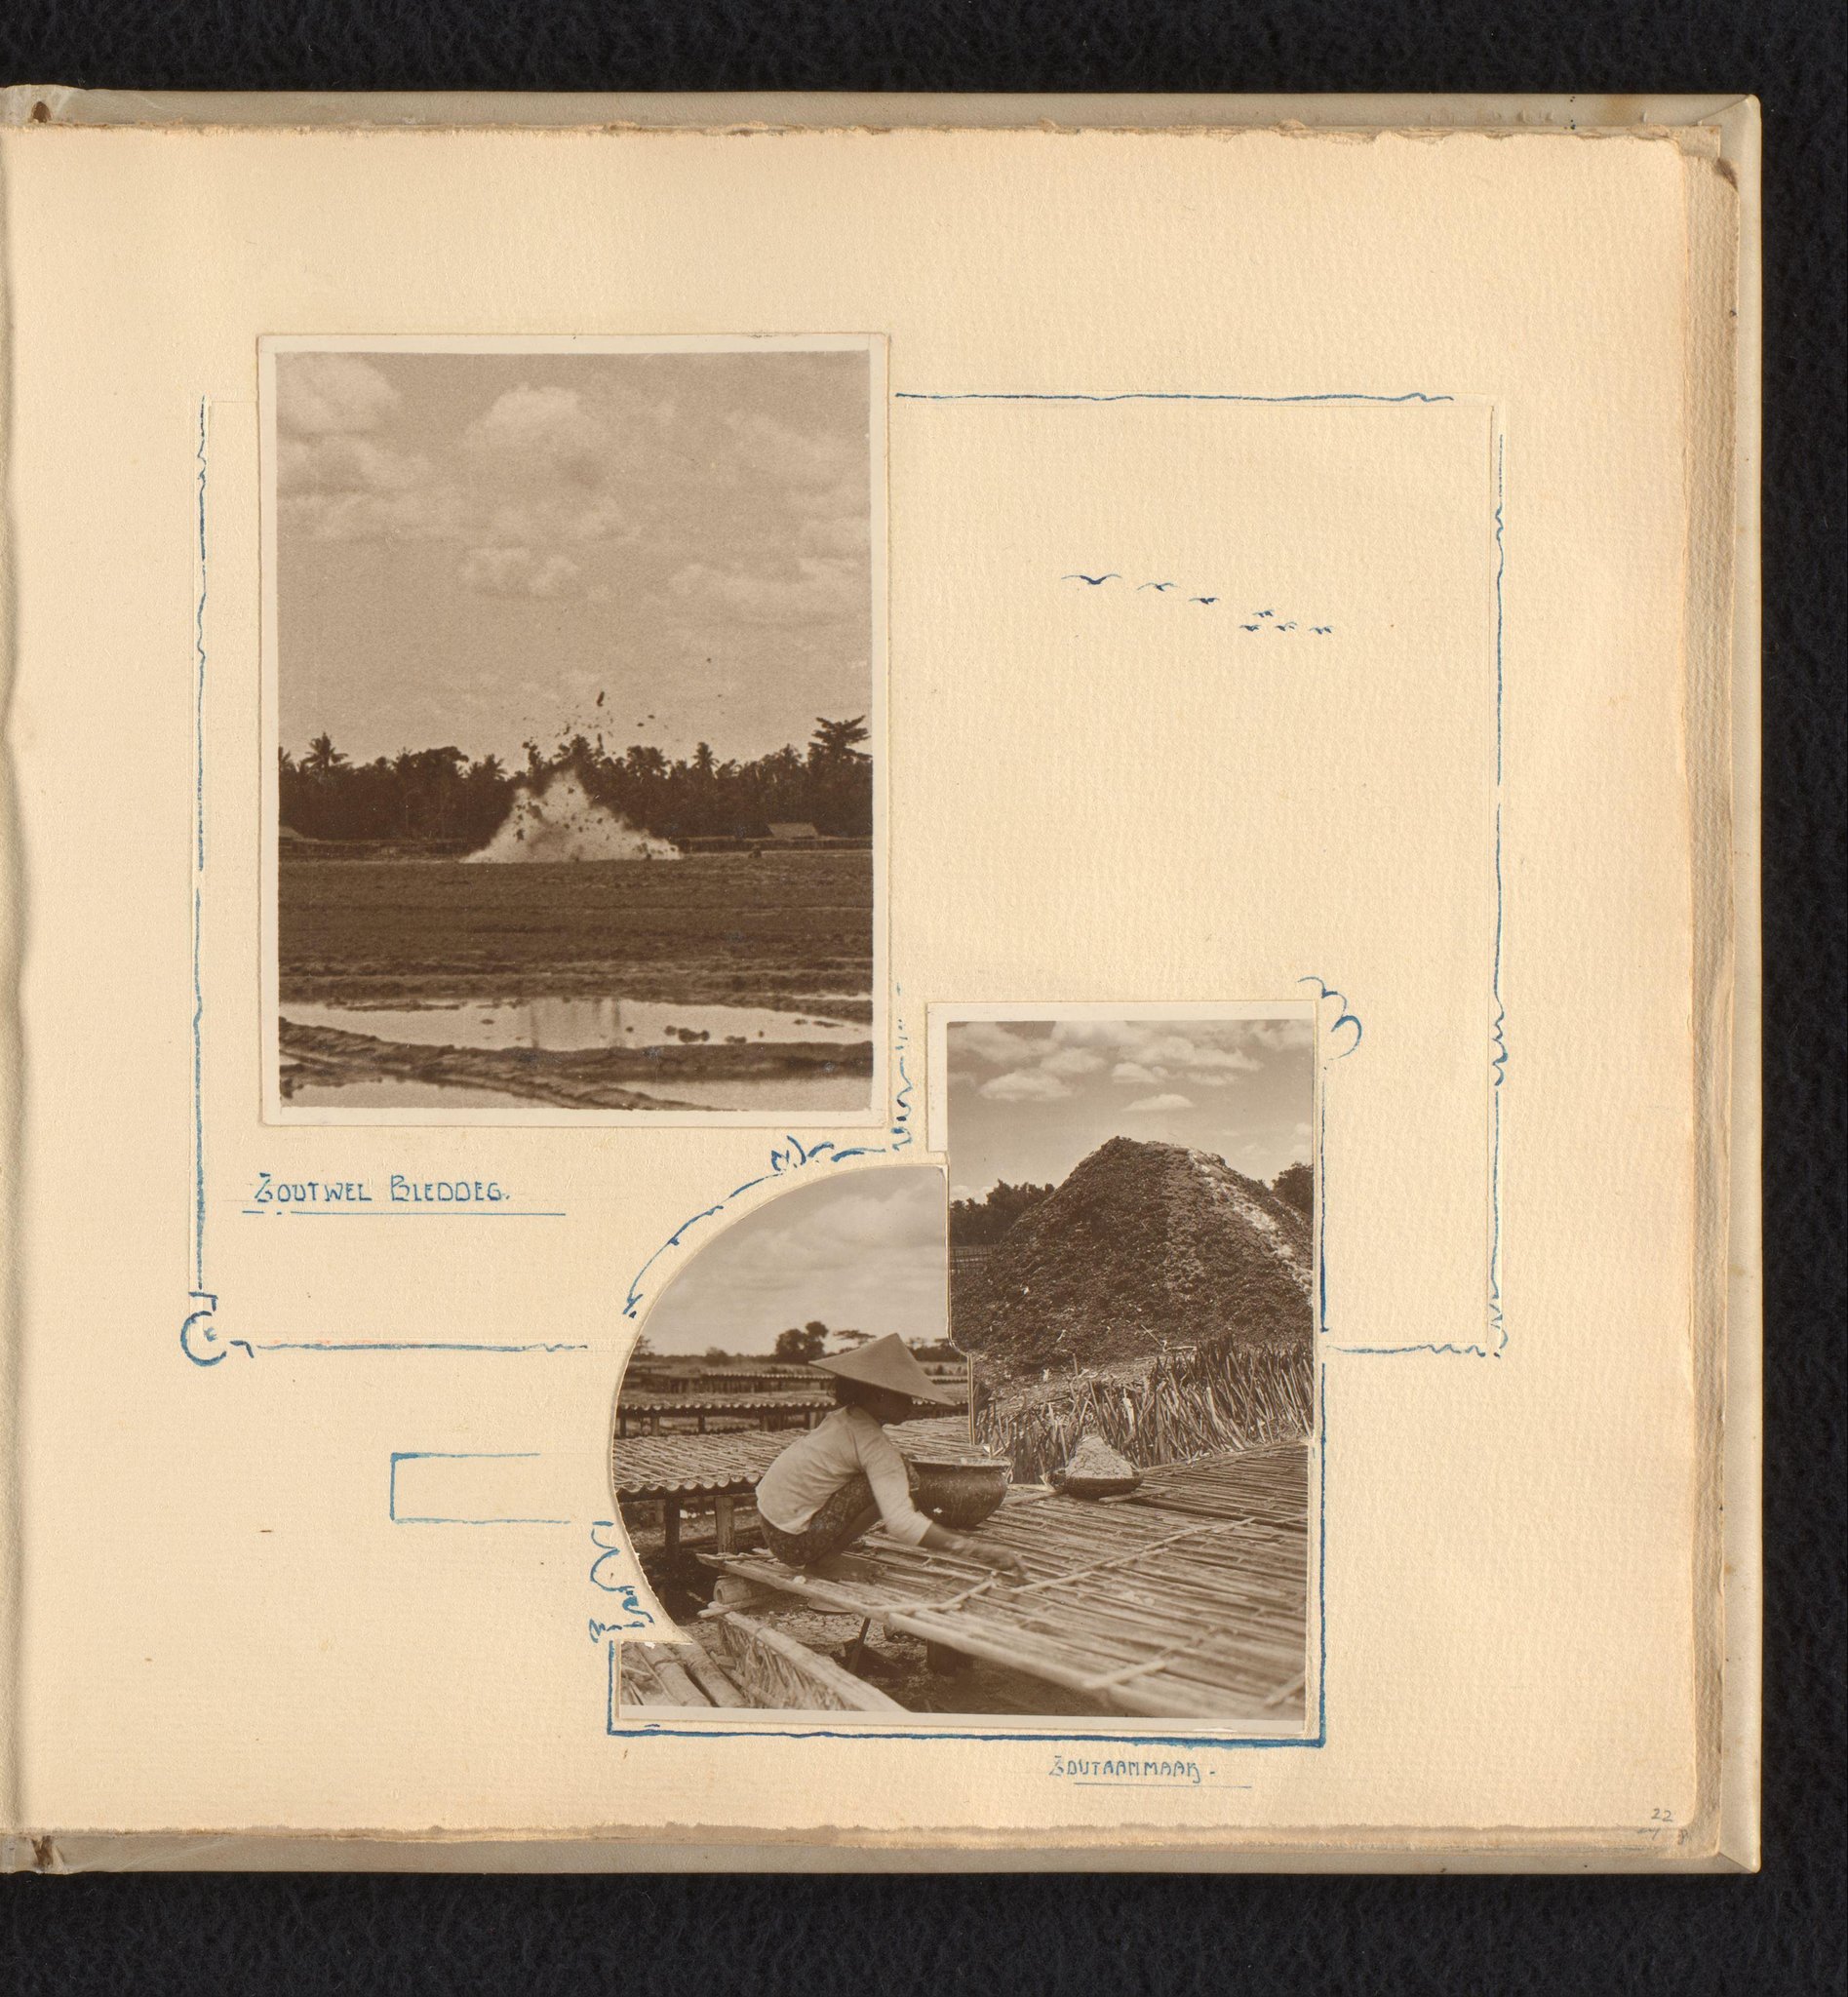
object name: album leaf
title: Zoutwinning in Grobogan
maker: Anonymous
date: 1910-1928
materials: paper, photographic support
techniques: drawing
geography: grobogan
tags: salt, mining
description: Albumblad met twee foto's van de zoutwinning in Grobogan. Het blad is versierd met enkele vogels en randwerk om de foto's. Onderdeel van het fotoalbum aangeboden aan J. Habbema door het Binnenlandsch Bestuur Corps van het Regentschap Grobogan, bij het beëindigen van zijn bestuur over het Regentschap, waarschijnlijk in 1928.